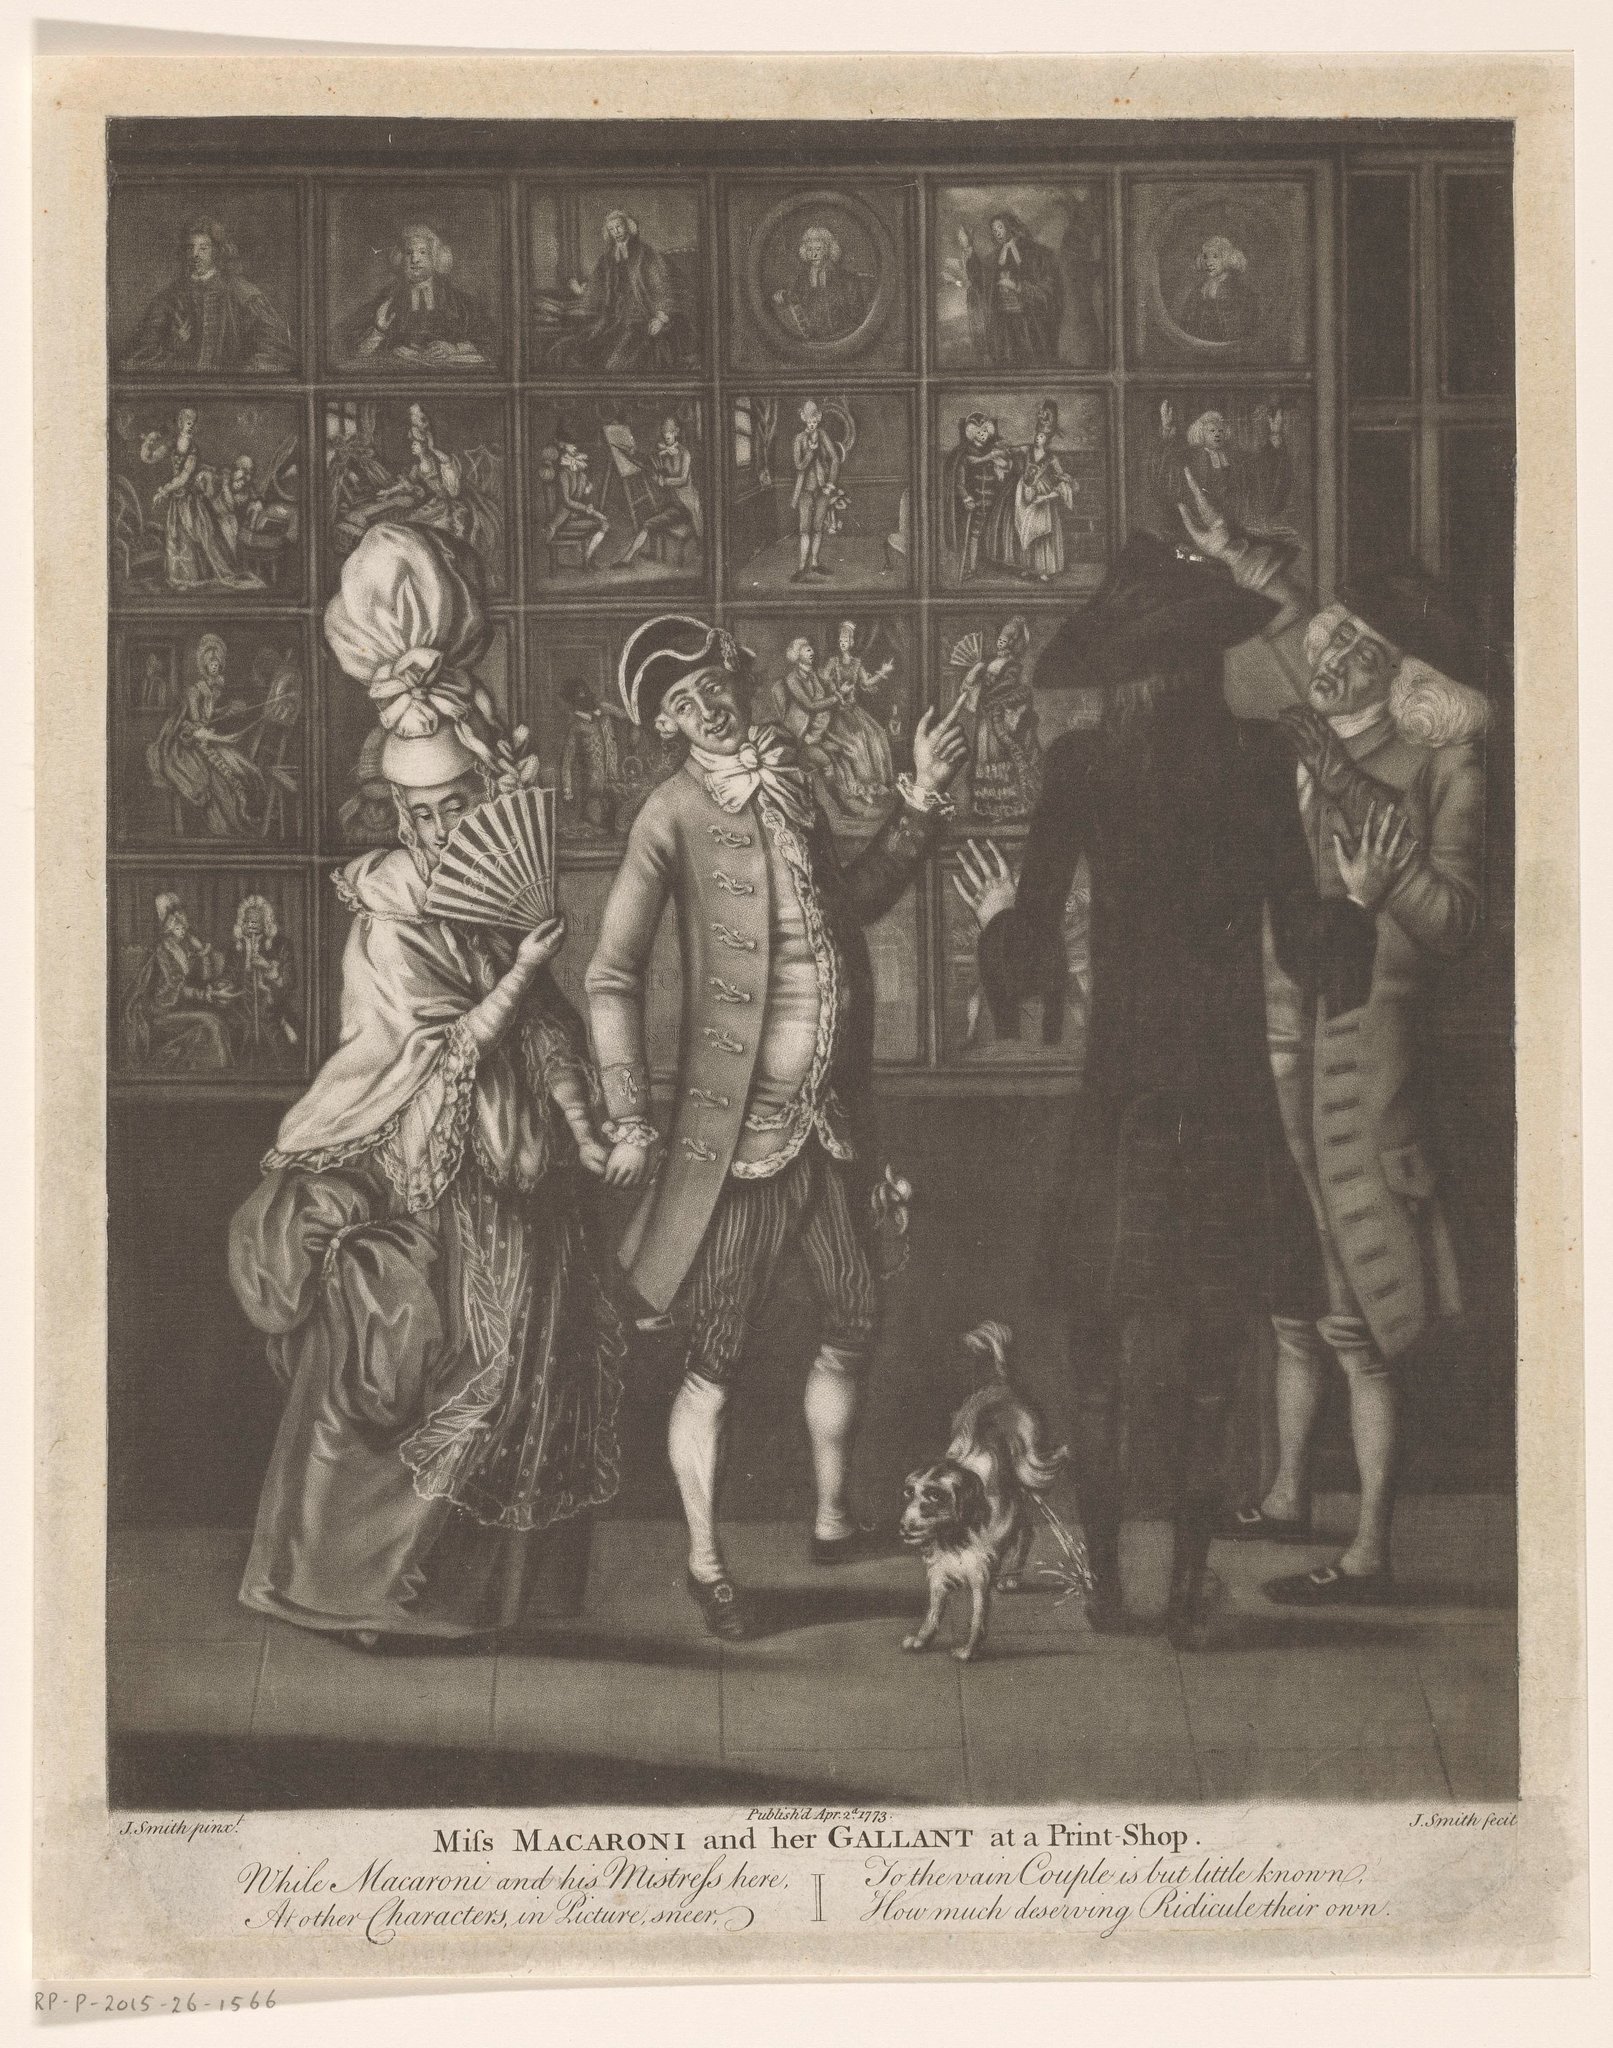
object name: print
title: Miss Macaroni en haar geliefde voor de etalage van een prenthandel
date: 1704-1773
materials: paper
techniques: mezzotint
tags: print, e.g.: engraving, etching, lithograph, art dealer (+ graphic arts), fan, fashion, political caricatures and satires, dog, shop-window, show-window, london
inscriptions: collector's mark: Lugt 2228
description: Een man en een vrouw in modieuze kleding staan hand in hand voor de etalage van een prenthandel. De vrouw heeft haar gezicht verborgen achter een opengevouwen waaier. Naast hen spreken twee mannen over prenten die in de etalage hangen. Een hond pist tegen het been van een van hen.